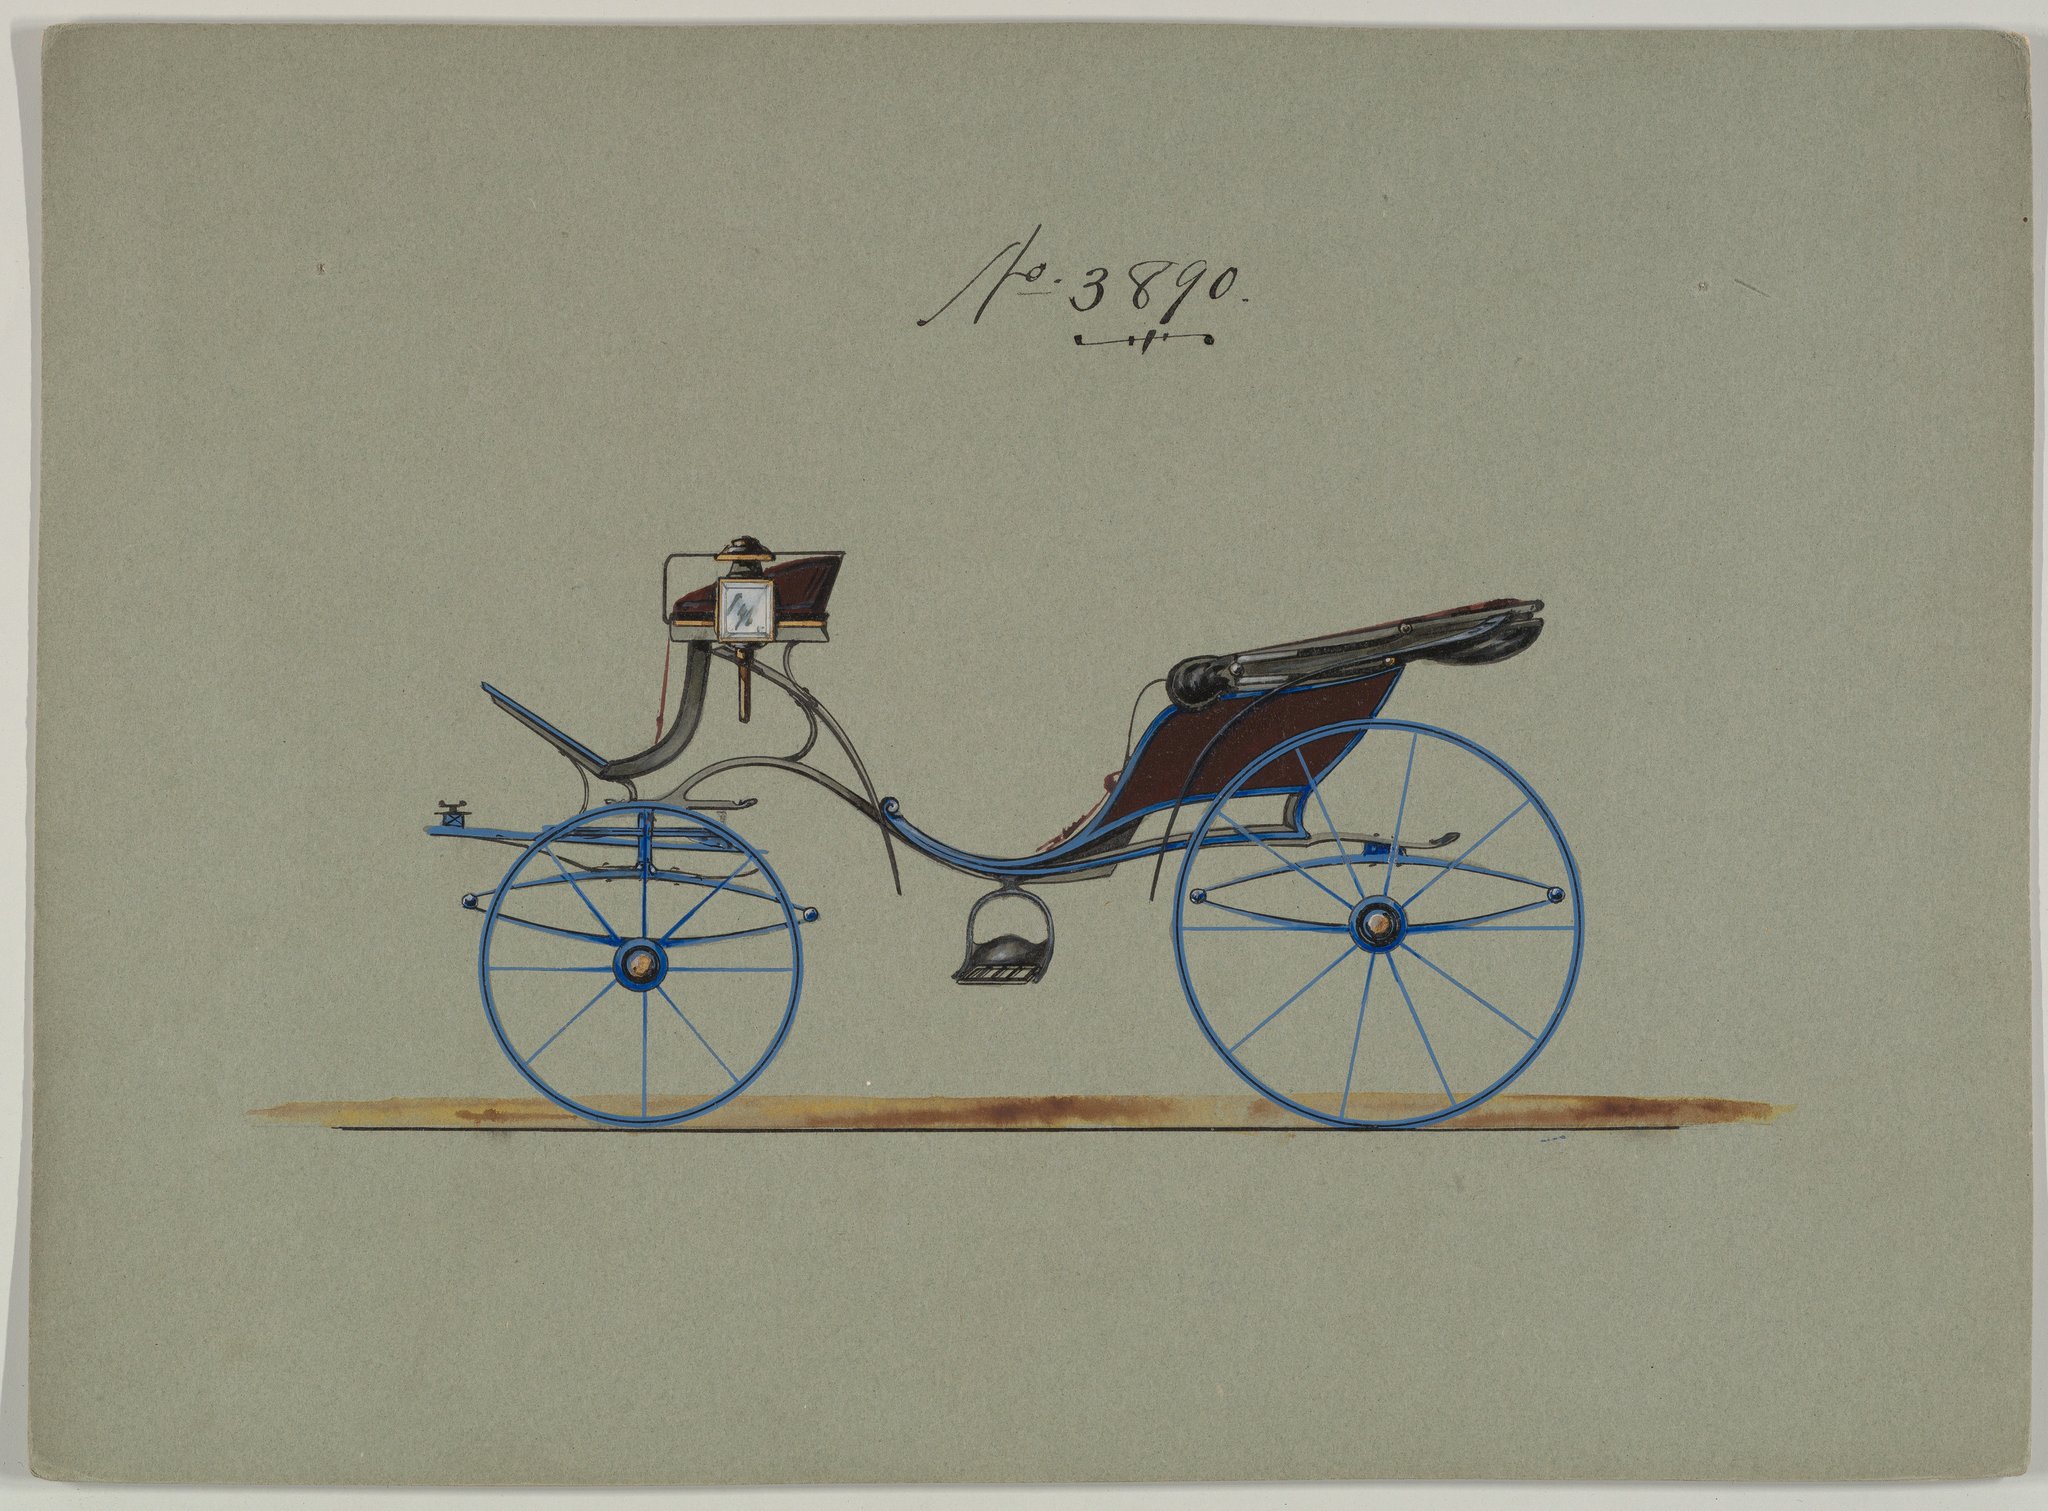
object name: drawing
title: Design for Cabriolet or Victoria, no. 3890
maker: brewster & co.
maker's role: manufacturer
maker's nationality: american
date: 1884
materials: gouache, ink, watercolor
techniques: pen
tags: carriages